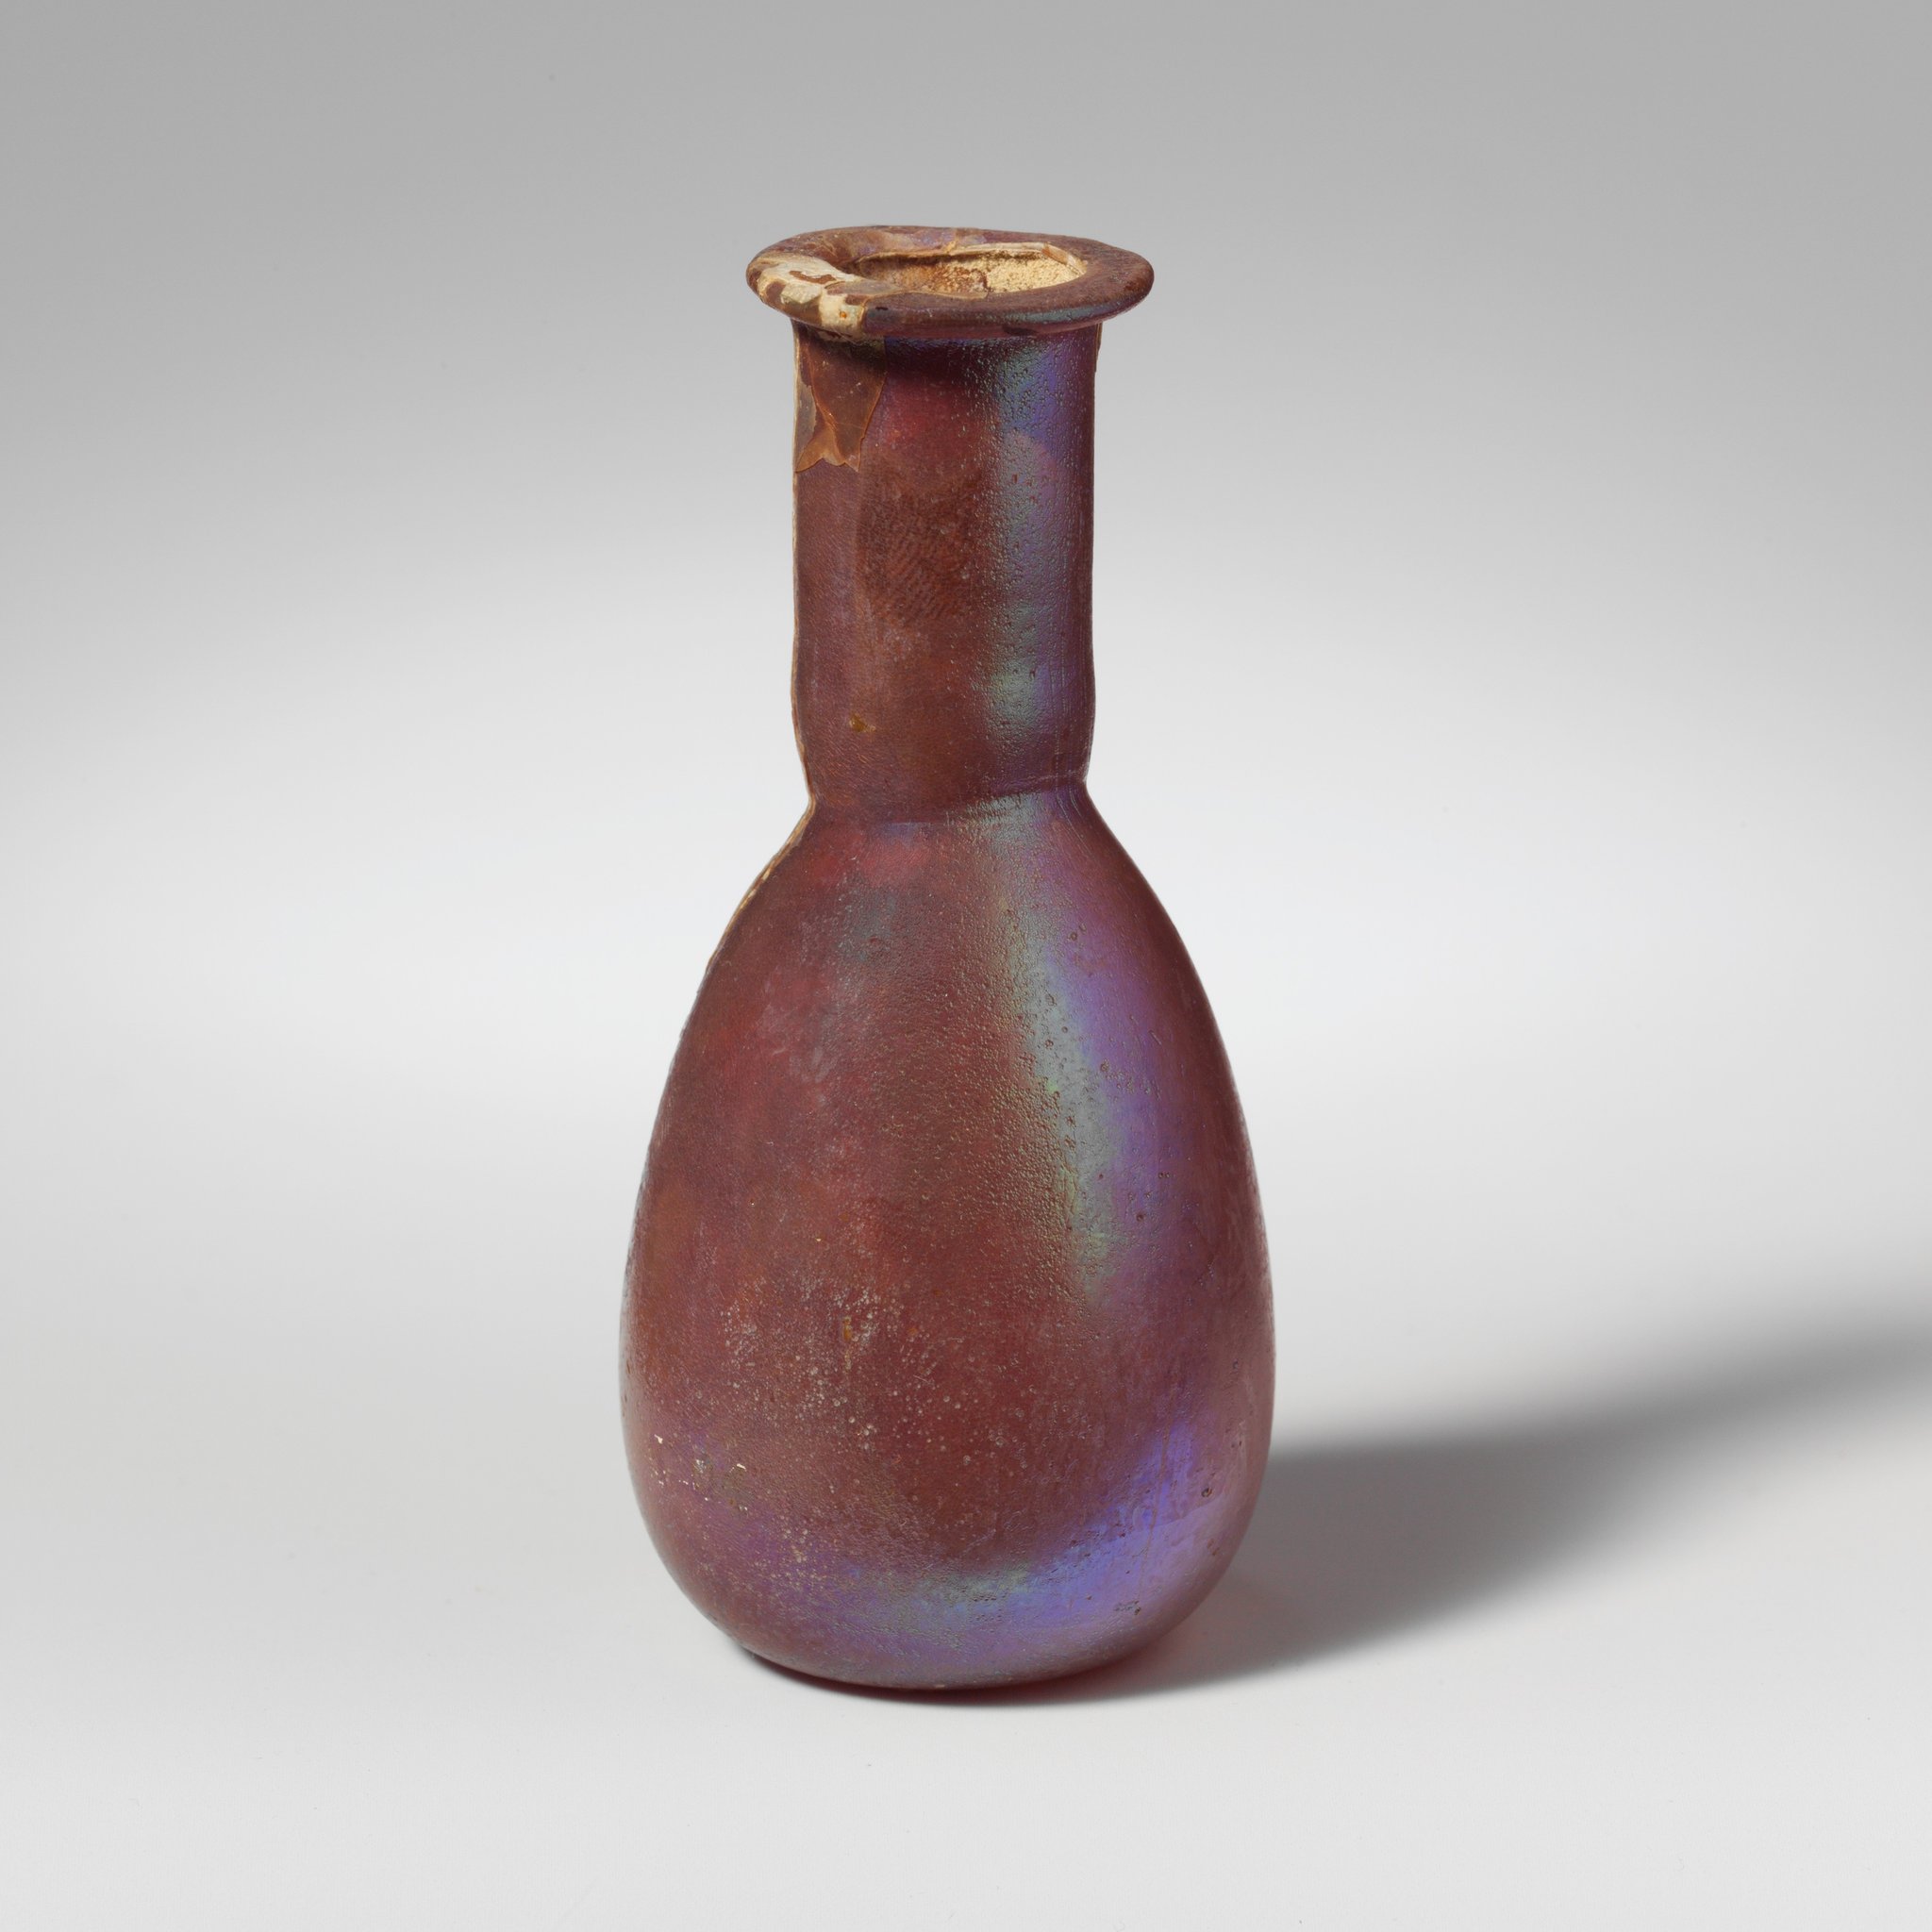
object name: perfume bottle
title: Glass perfume bottle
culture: roman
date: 1-100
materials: glass